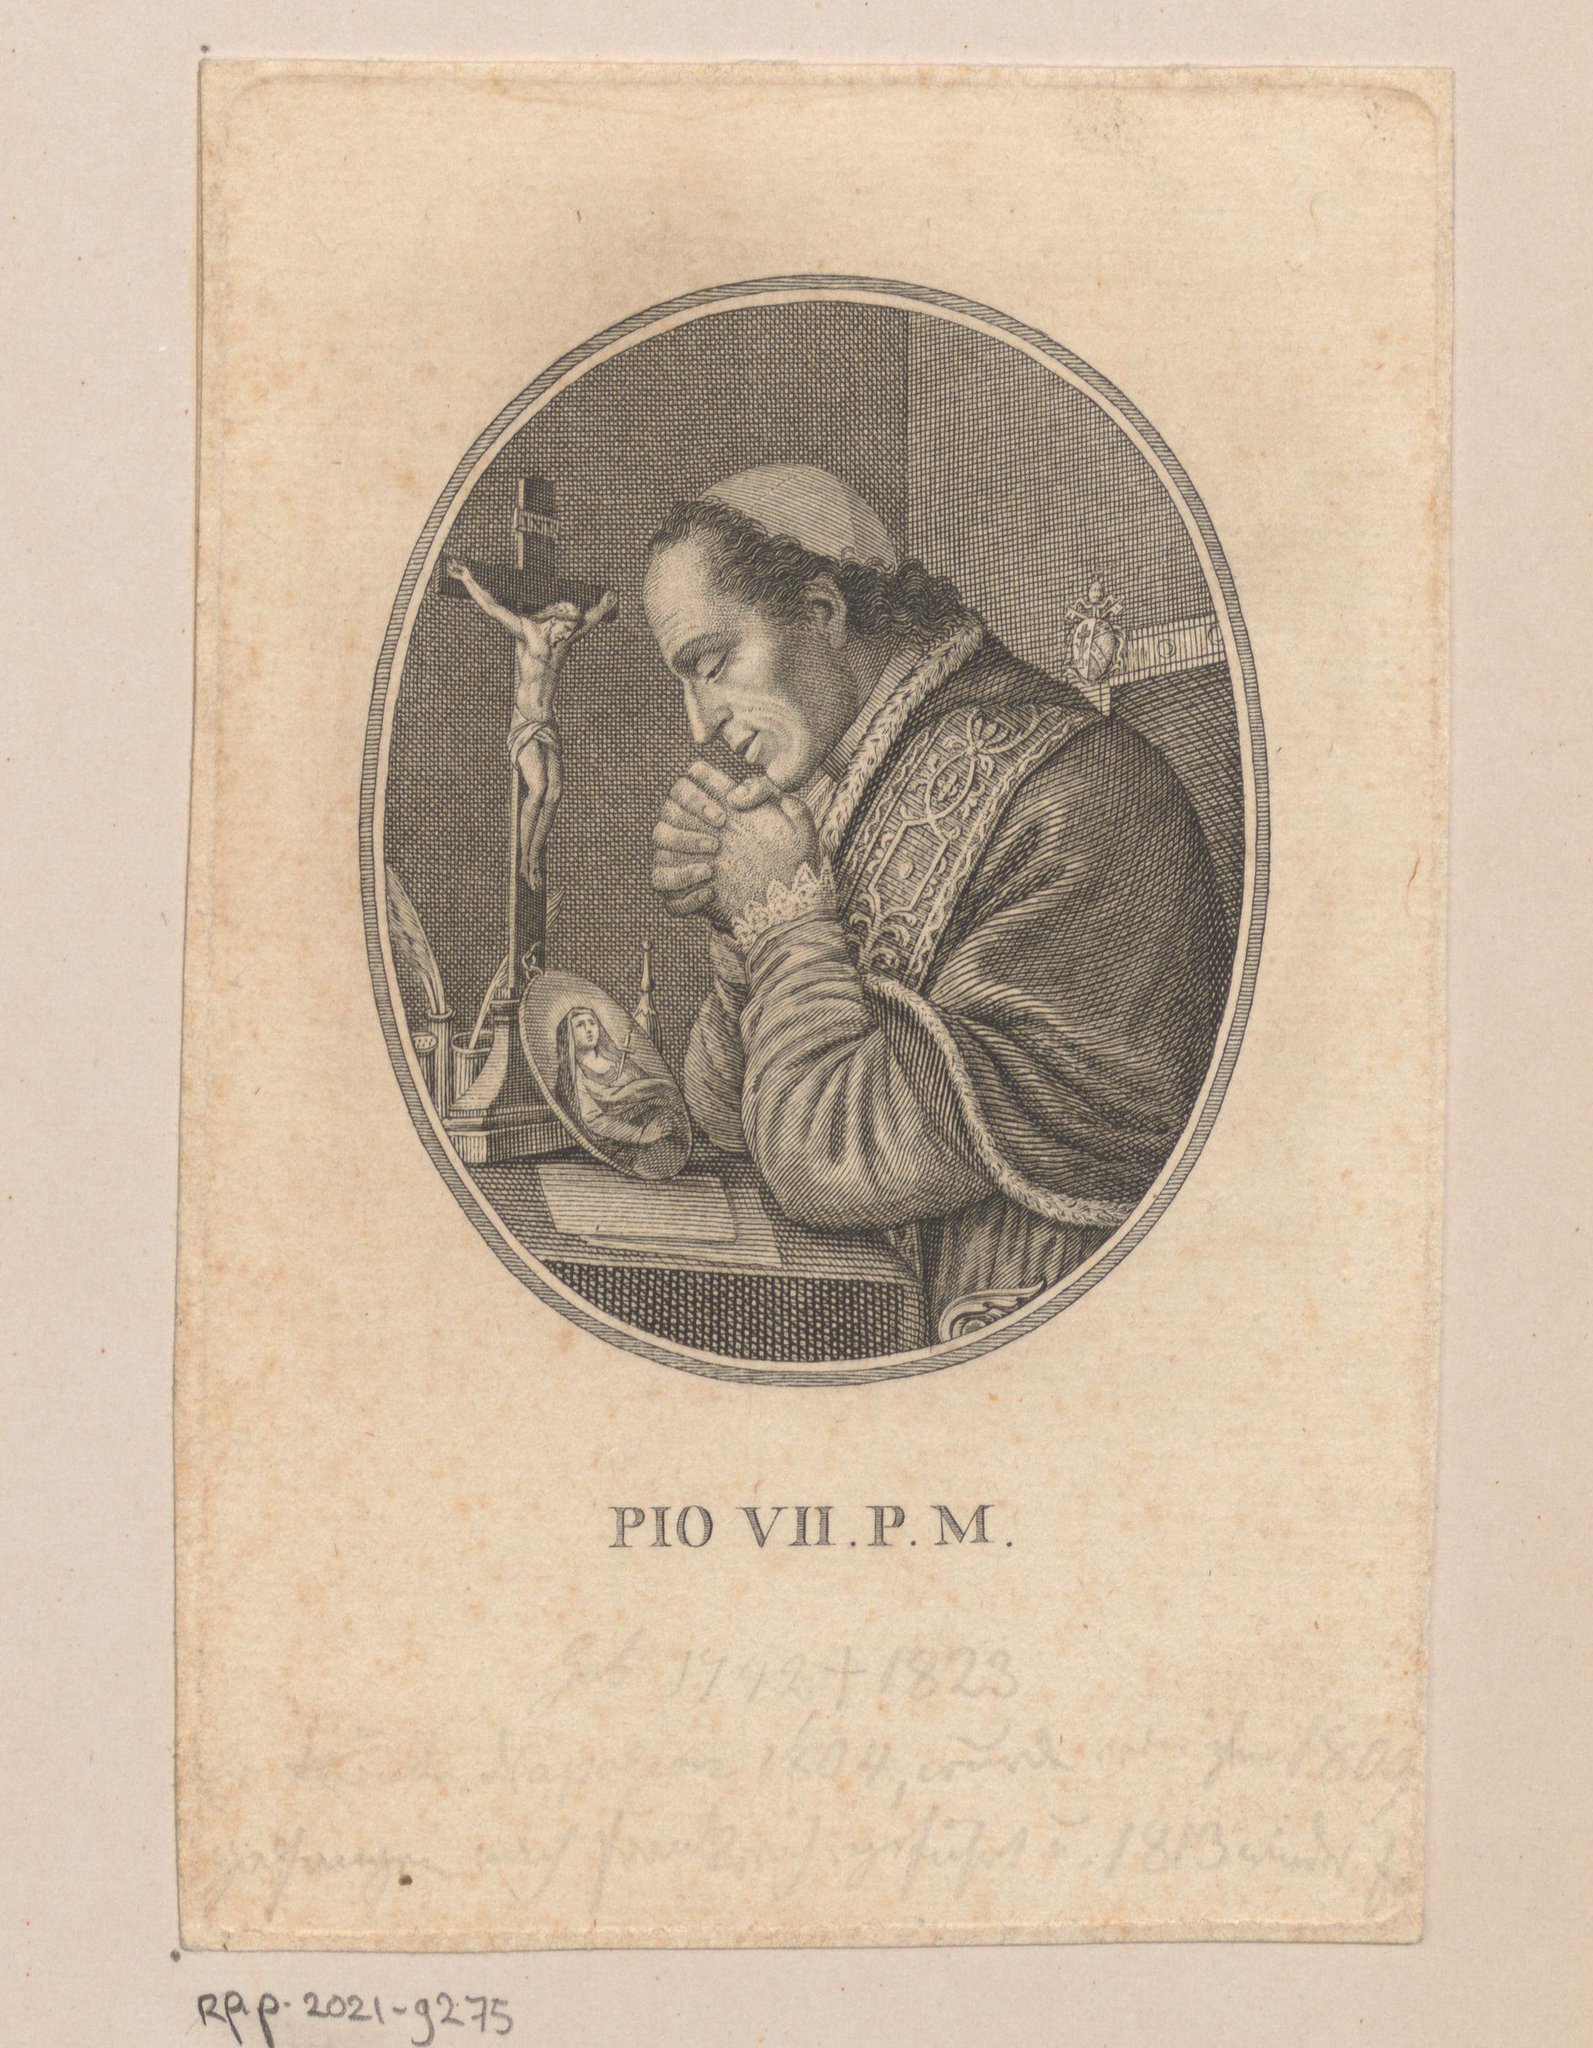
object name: print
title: Portret van paus Pius VII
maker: Anonymous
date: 1800-1849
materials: paper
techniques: engraving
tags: rome, clergyman, pius vii, (veneration of) devotional objects, historical persons, pope